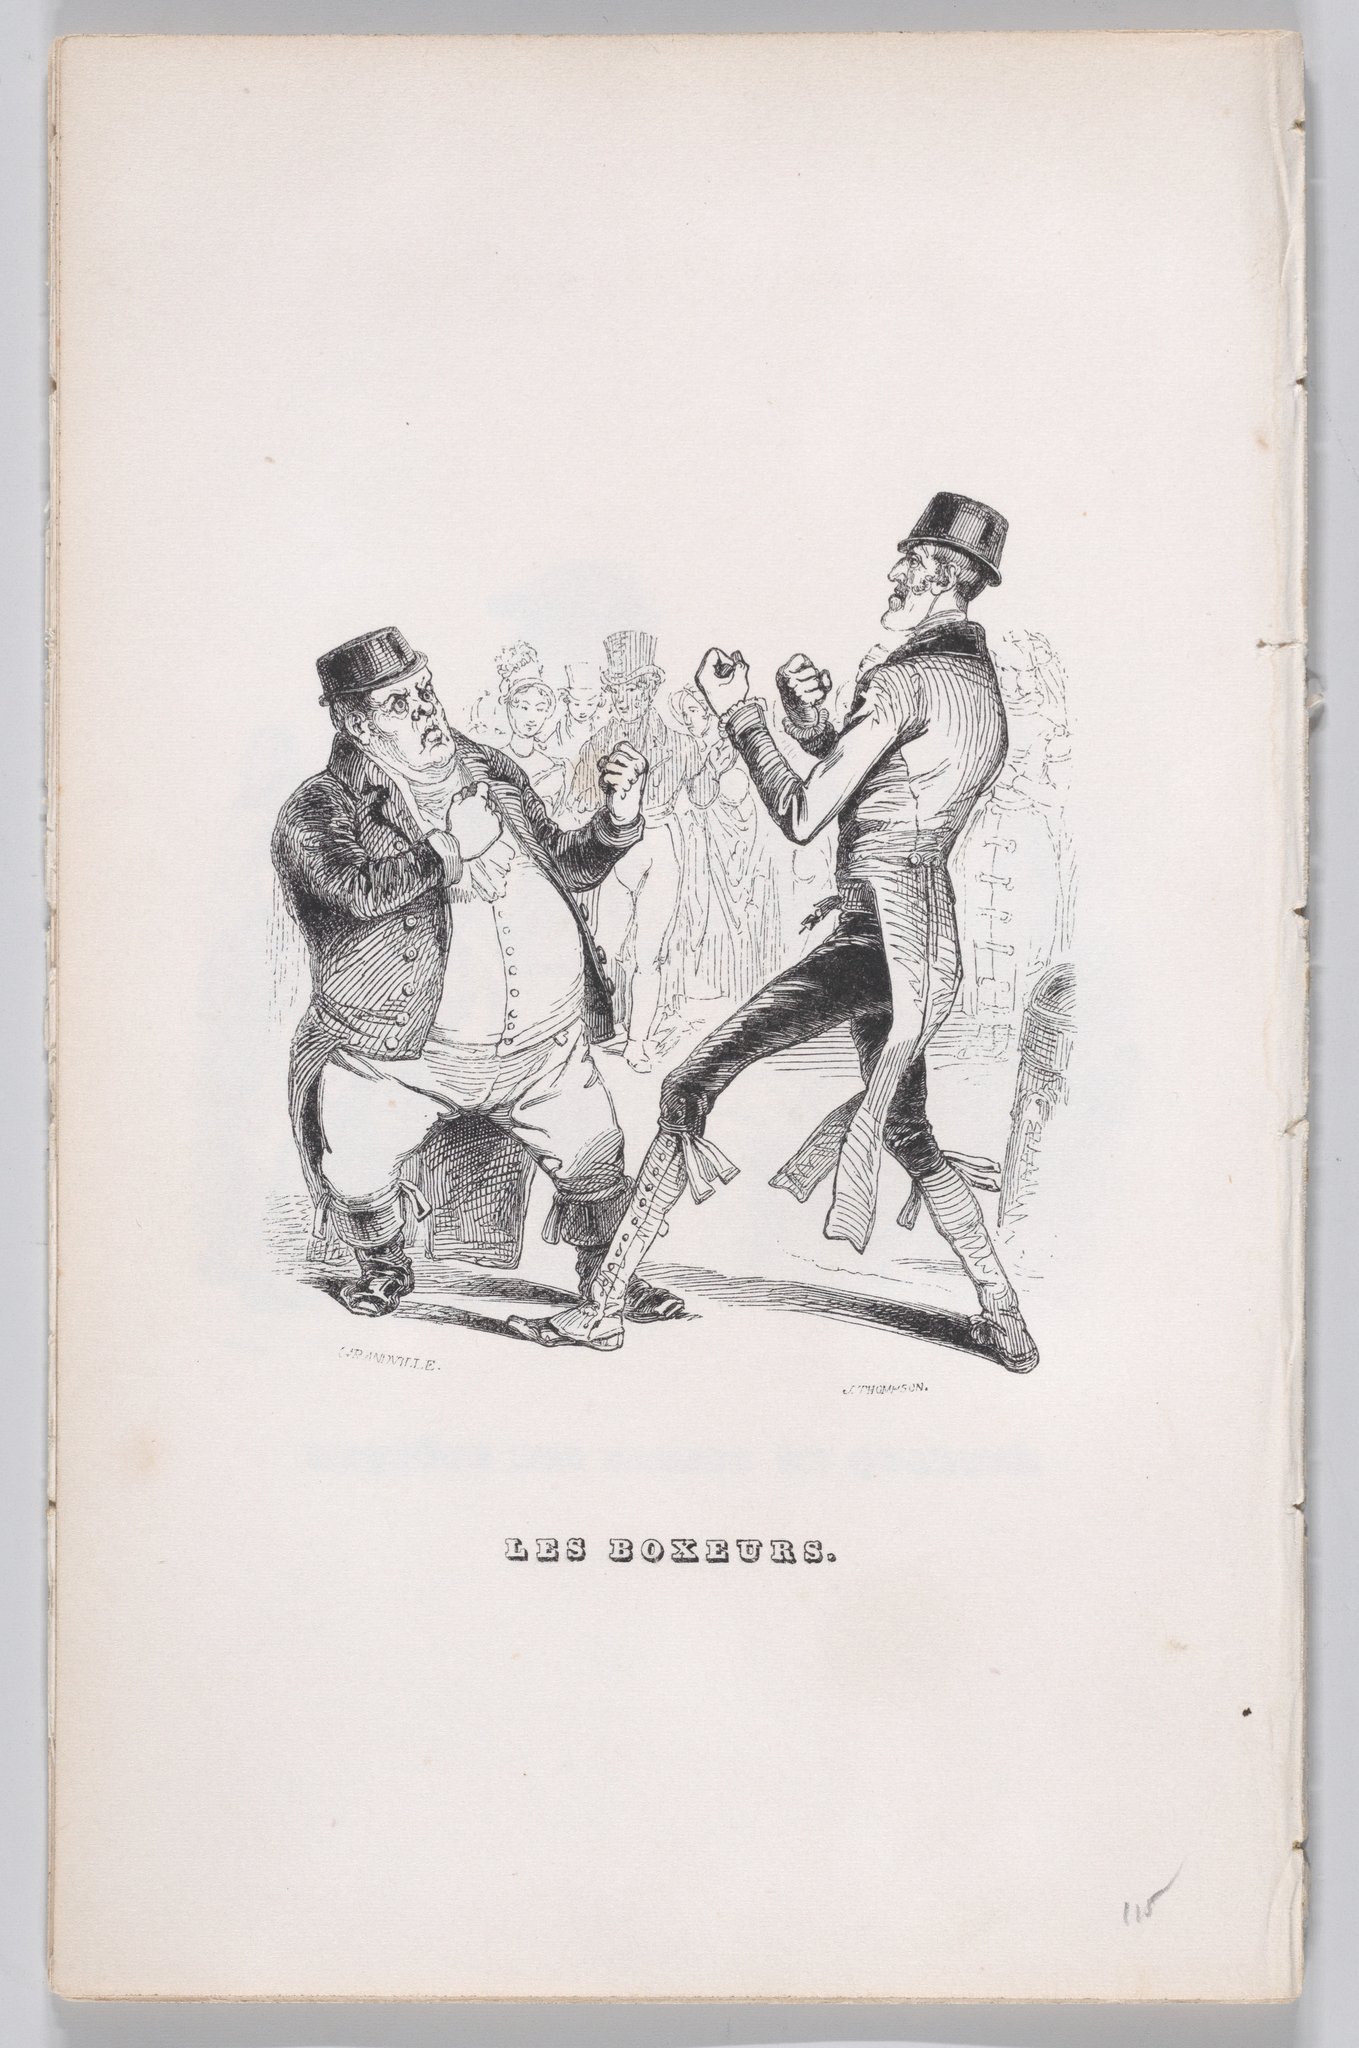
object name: print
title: The Boxers, from "The Complete Works of Béranger"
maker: j. j. grandville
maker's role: illustrator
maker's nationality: french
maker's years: 1803-1847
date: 1836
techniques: engraving